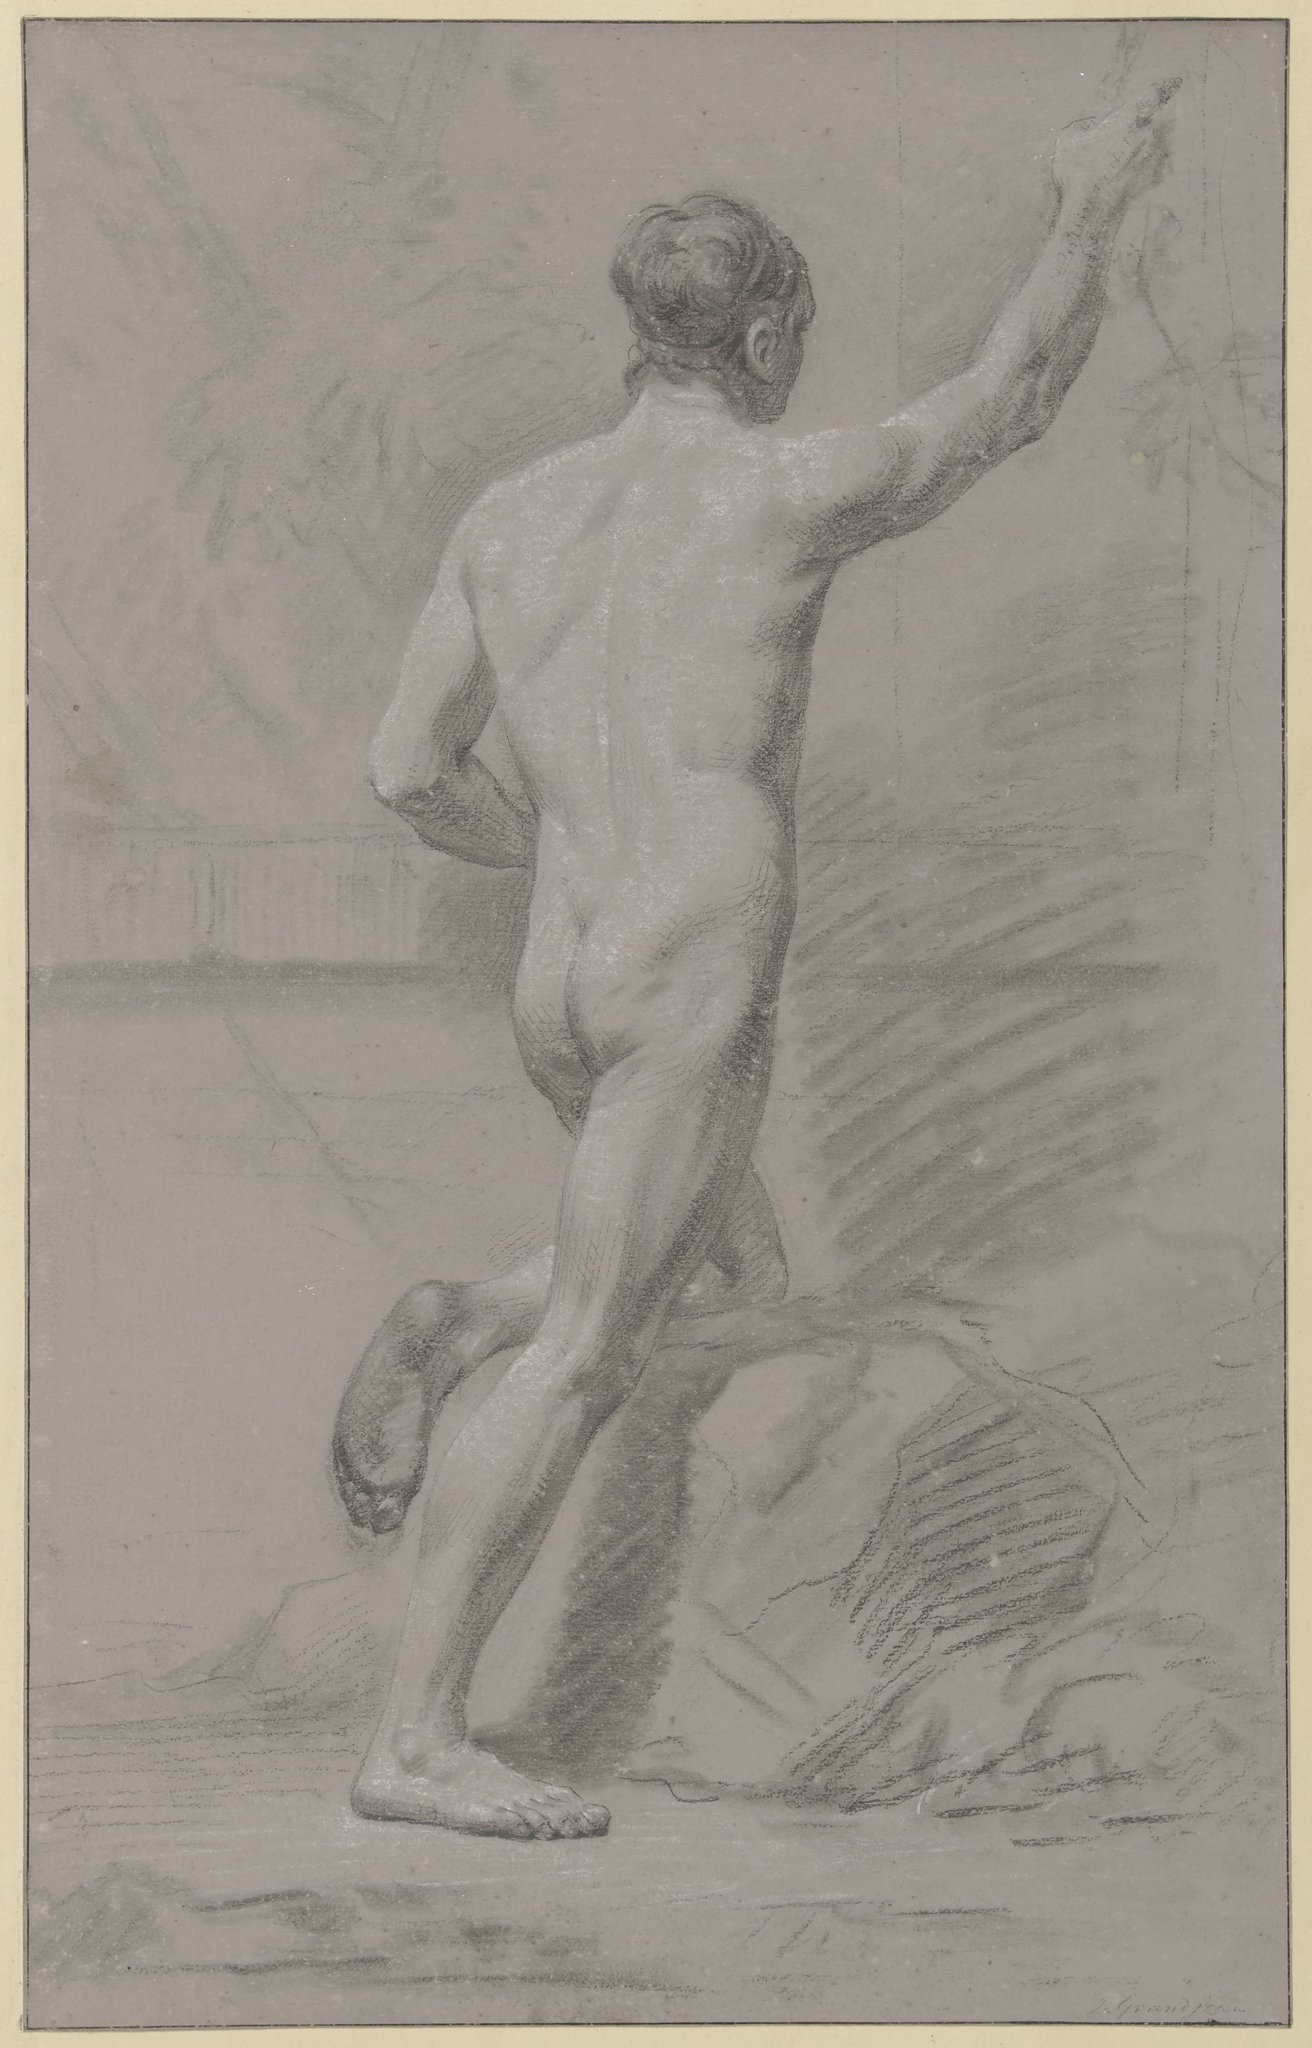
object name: drawing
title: Staand mannelijk naakt, de linkerknie op een rots, de rechterarm geheven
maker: jean grandjean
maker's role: draughtsman, print maker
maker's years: 1752-1781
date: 1765-1781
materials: chalk, paper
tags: standing figure